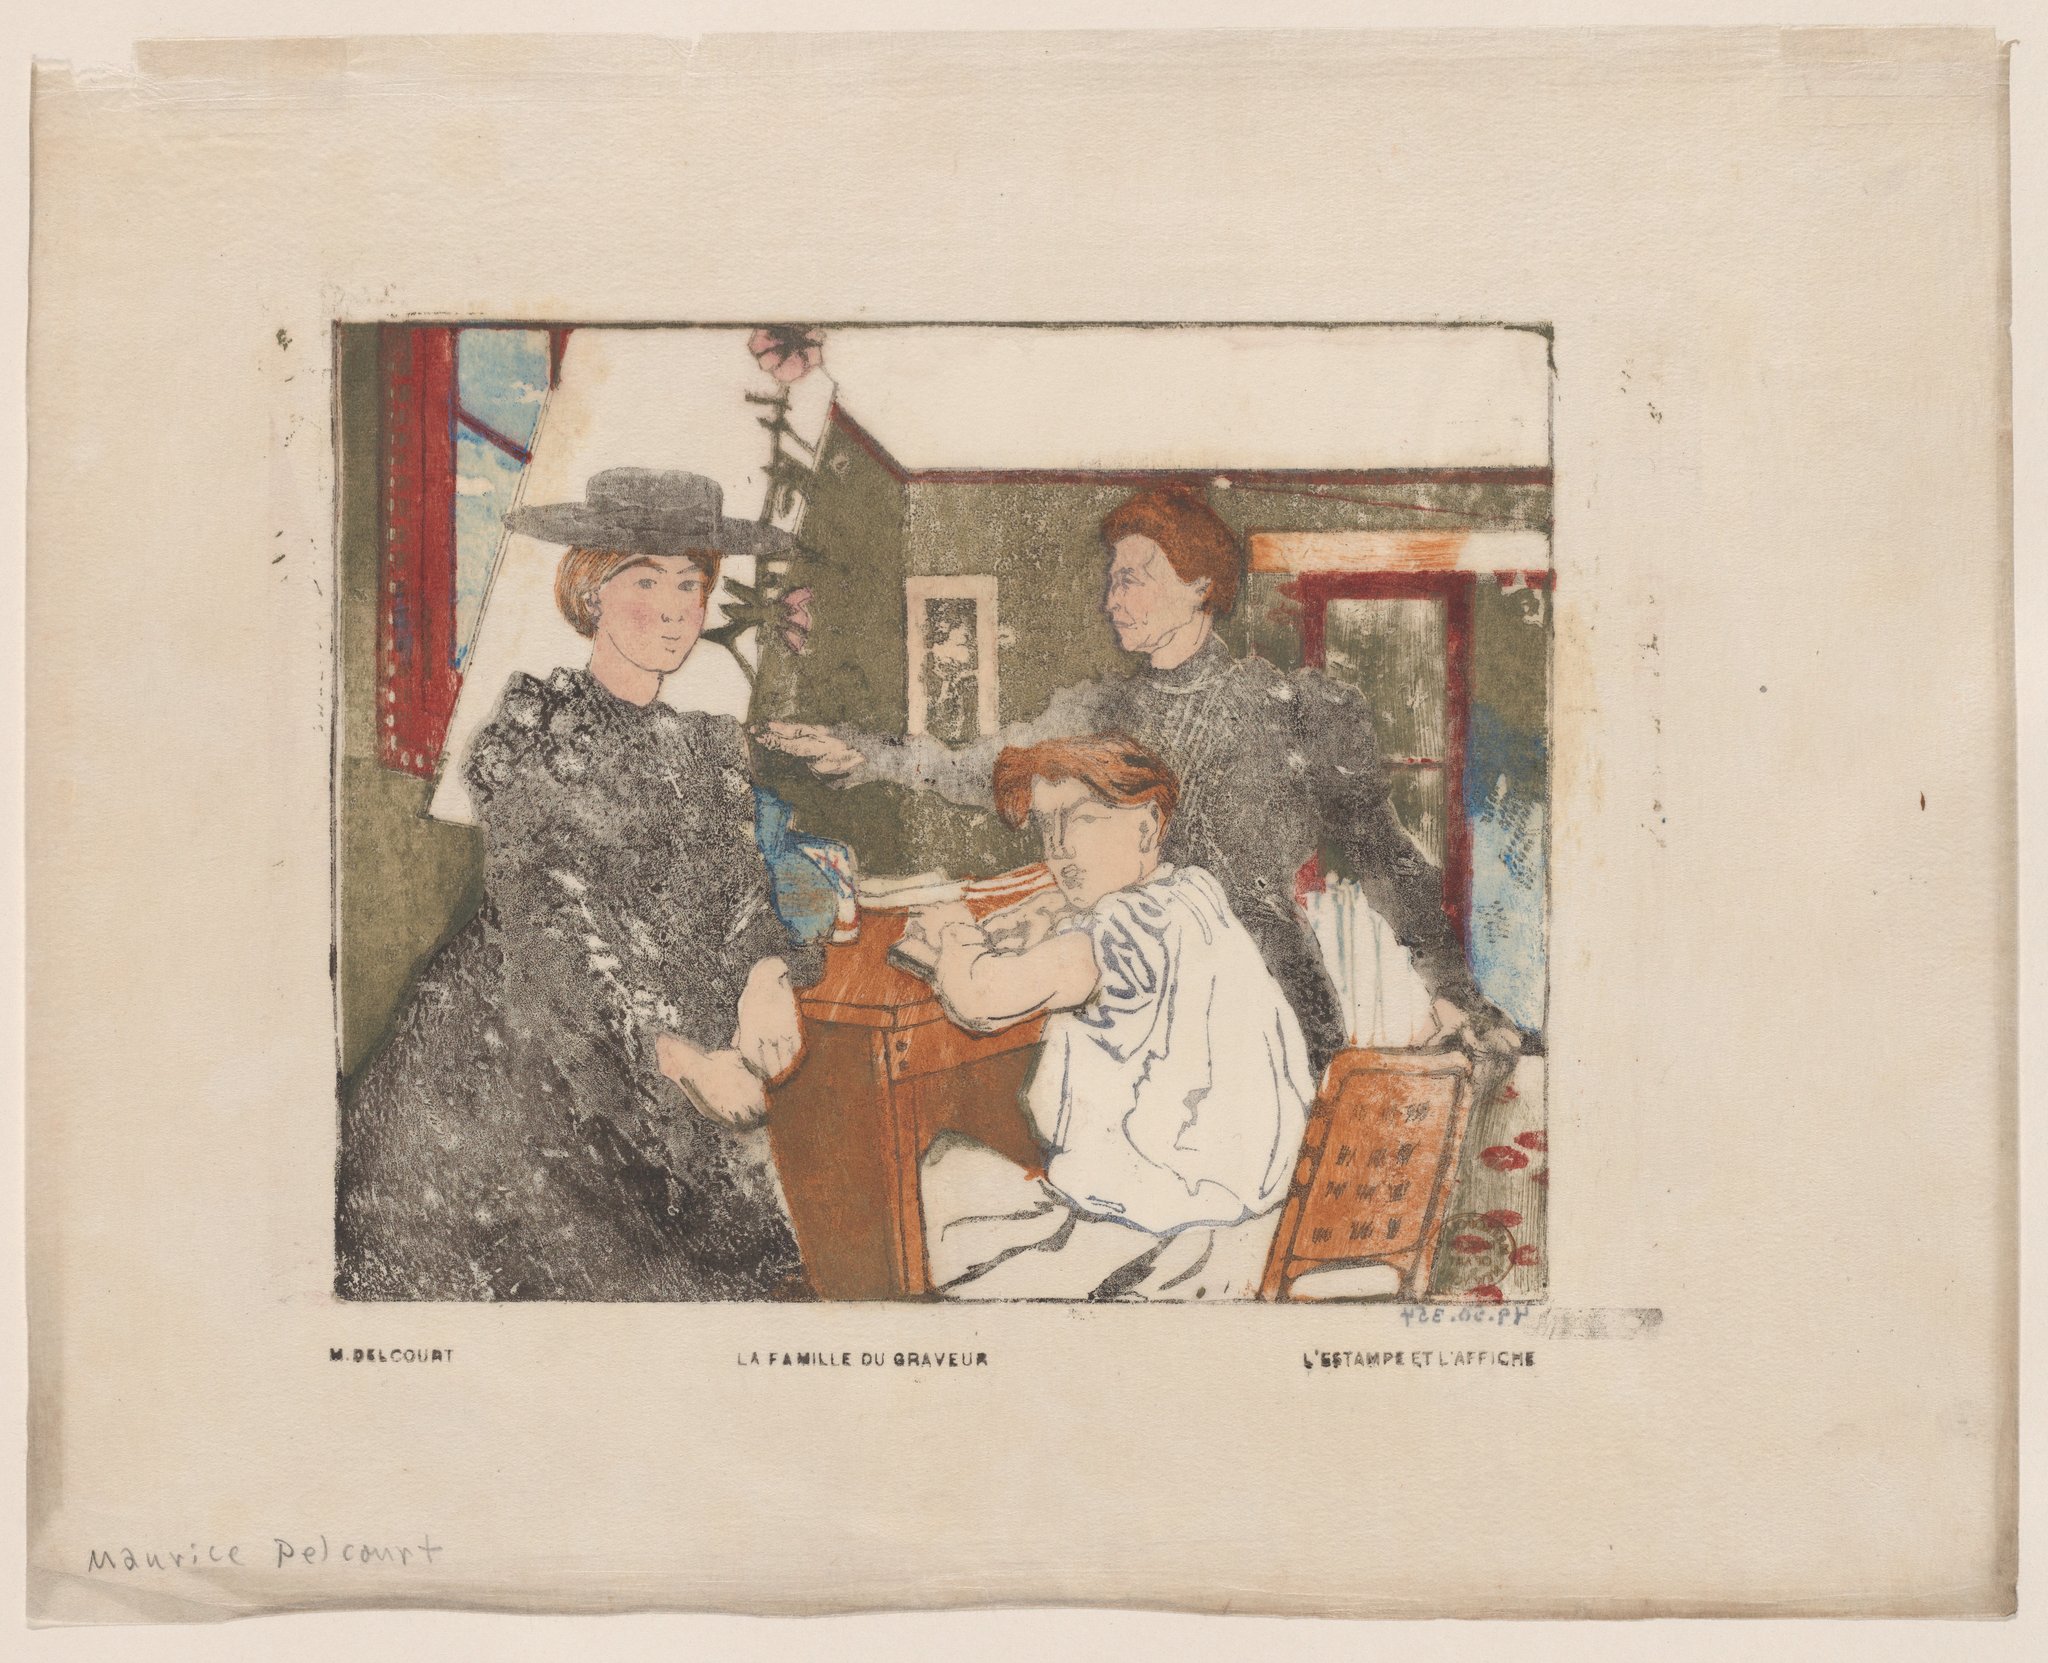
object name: print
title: La Famille du graveur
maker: maurice delcourt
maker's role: artist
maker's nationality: french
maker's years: 1877-1916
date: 1898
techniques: woodcut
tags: children,women,desks